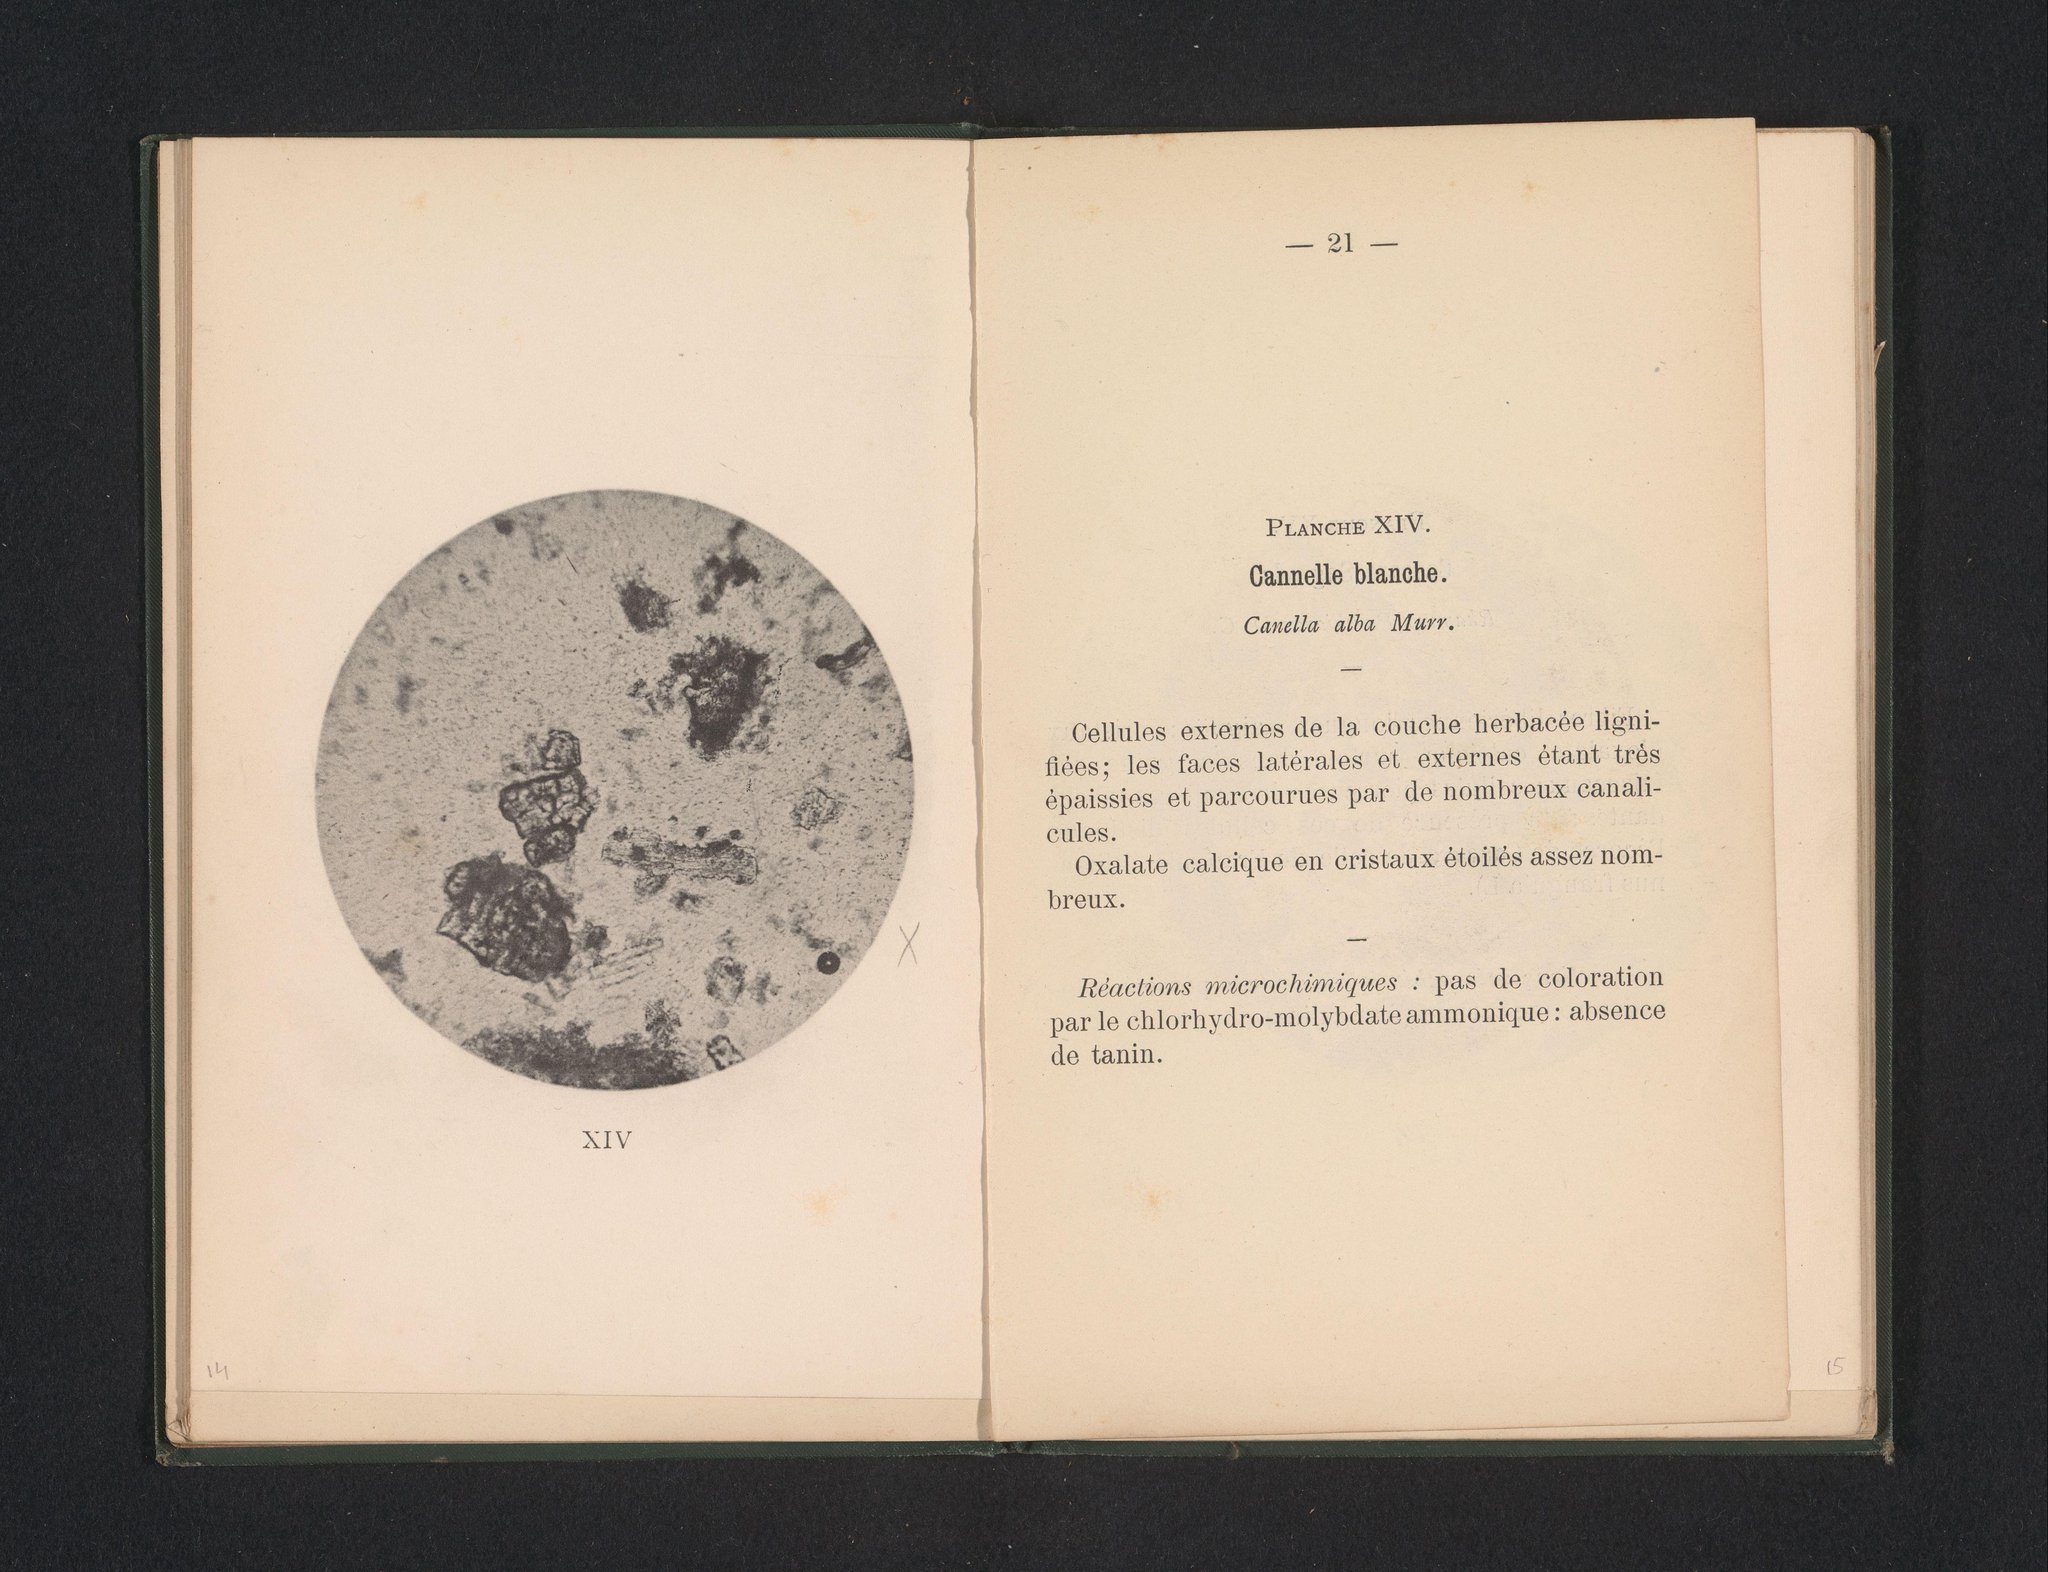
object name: photomechanical print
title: Microscopische weergave van witte kaneel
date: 1891-1896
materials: paper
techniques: photograph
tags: microscope (+ scientific research)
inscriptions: number: ‘XIV’